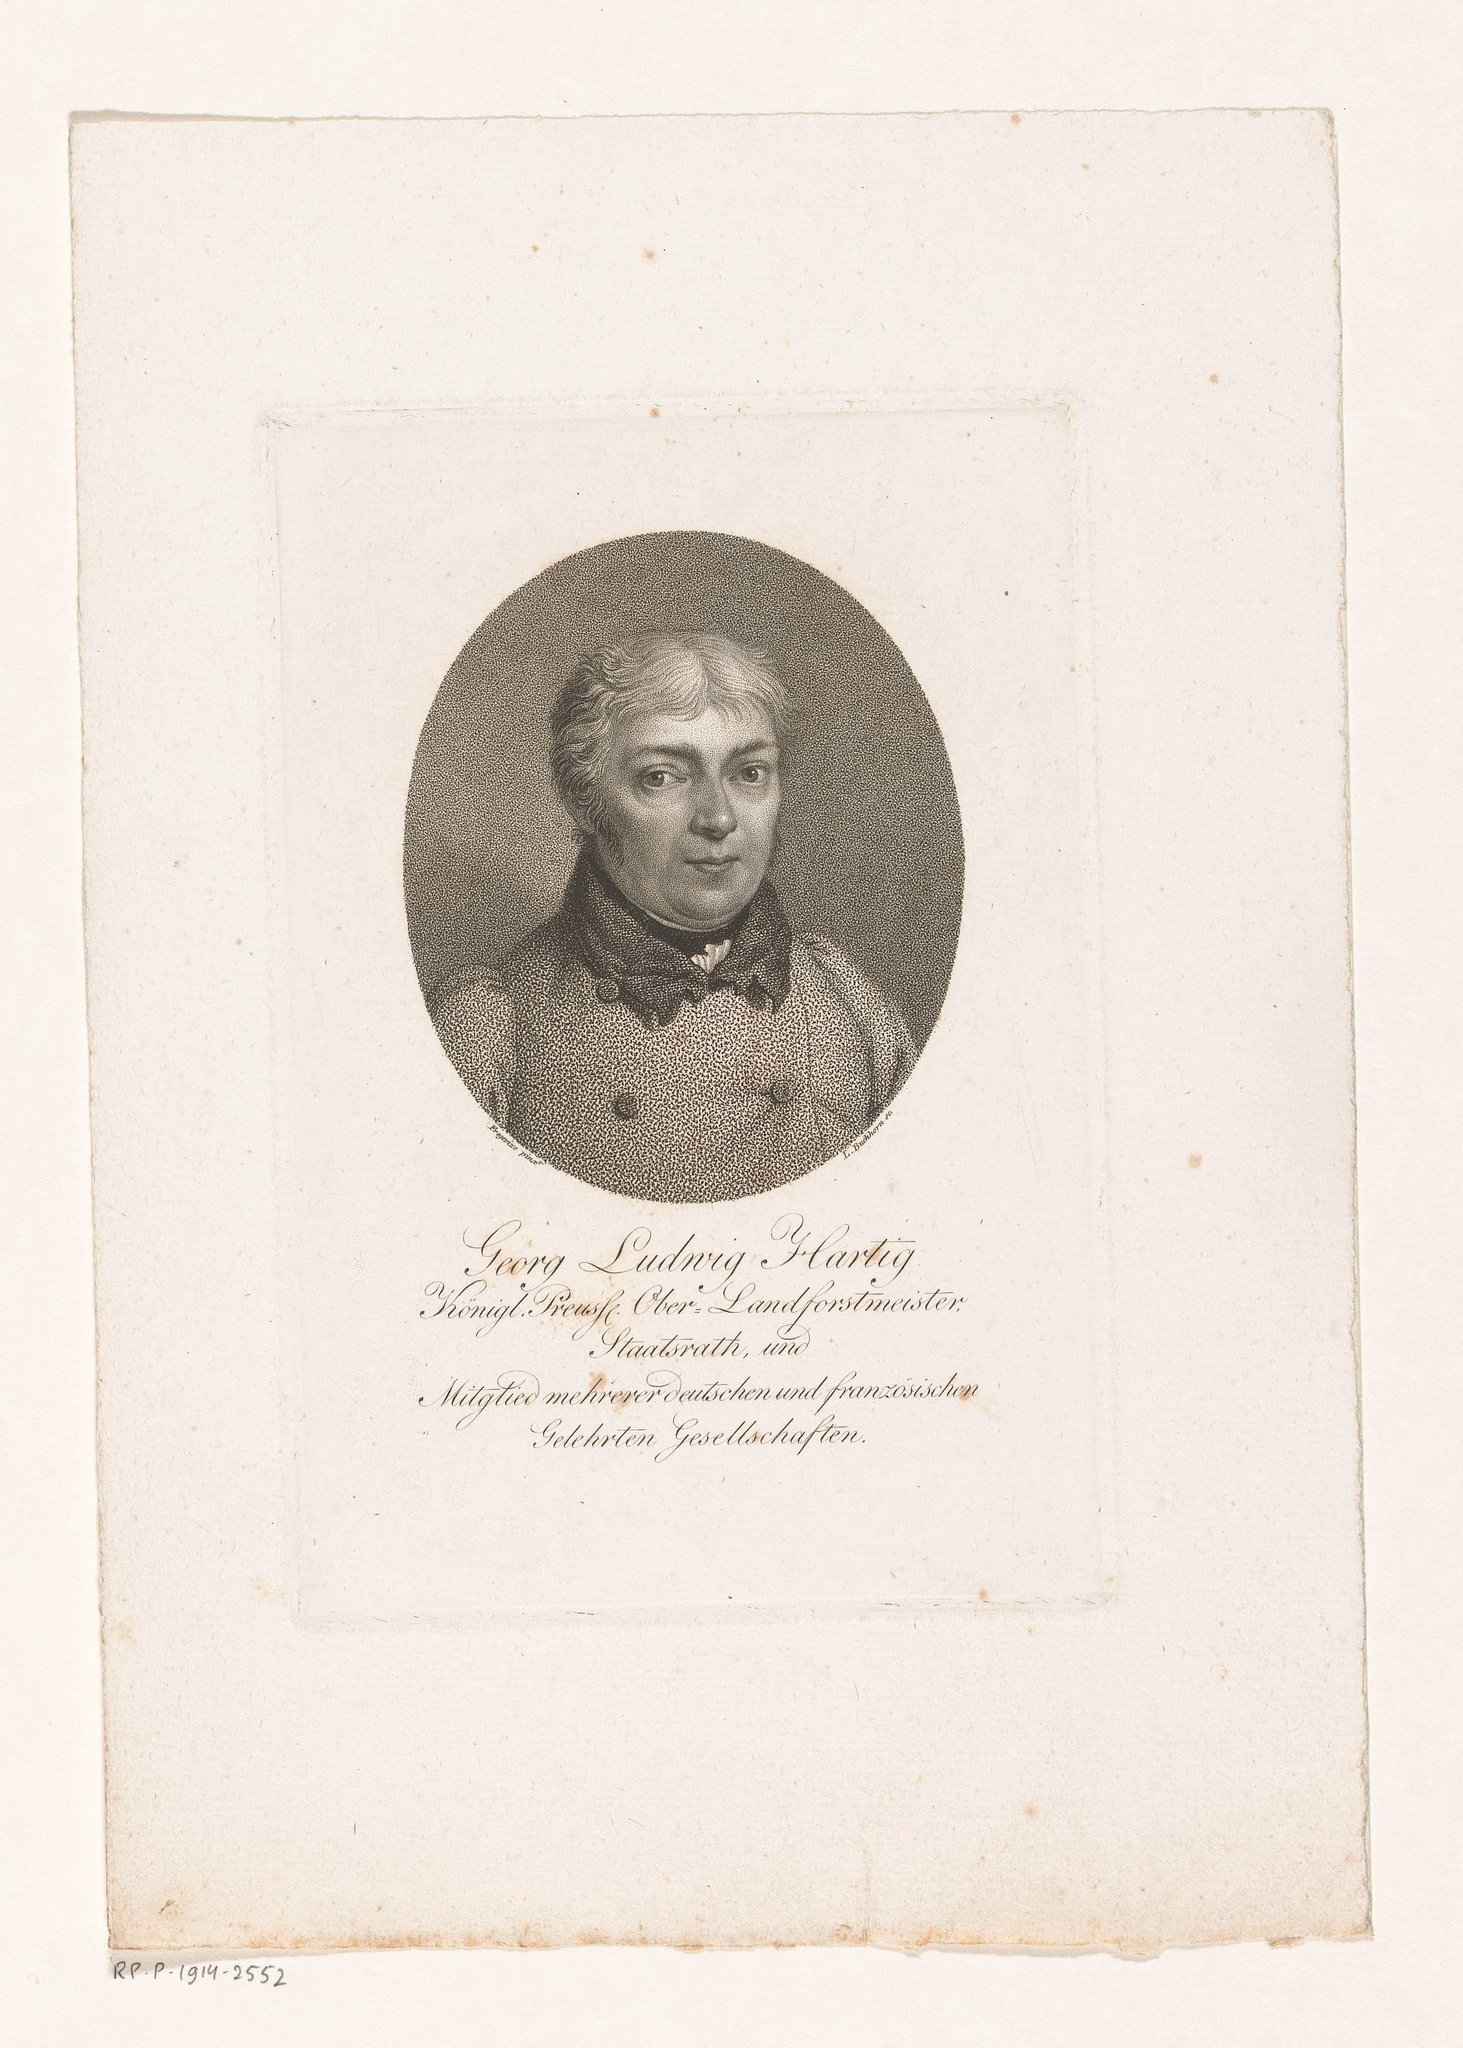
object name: print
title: Portret van Georg Ludwig Hartig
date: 1816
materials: paper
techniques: stippling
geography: berlin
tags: berlin, historical persons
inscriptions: collector's mark: Lugt 2228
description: Prent ook gebruikt in: Leurop, C.P. en Fischer, V.F. Sylvan ein Jahrbuch für Forstmänner, Jäger und Jagdfreunde aus das Jahr 1816. Marburg en Cassel: Johann Christian Krieger, [1816].